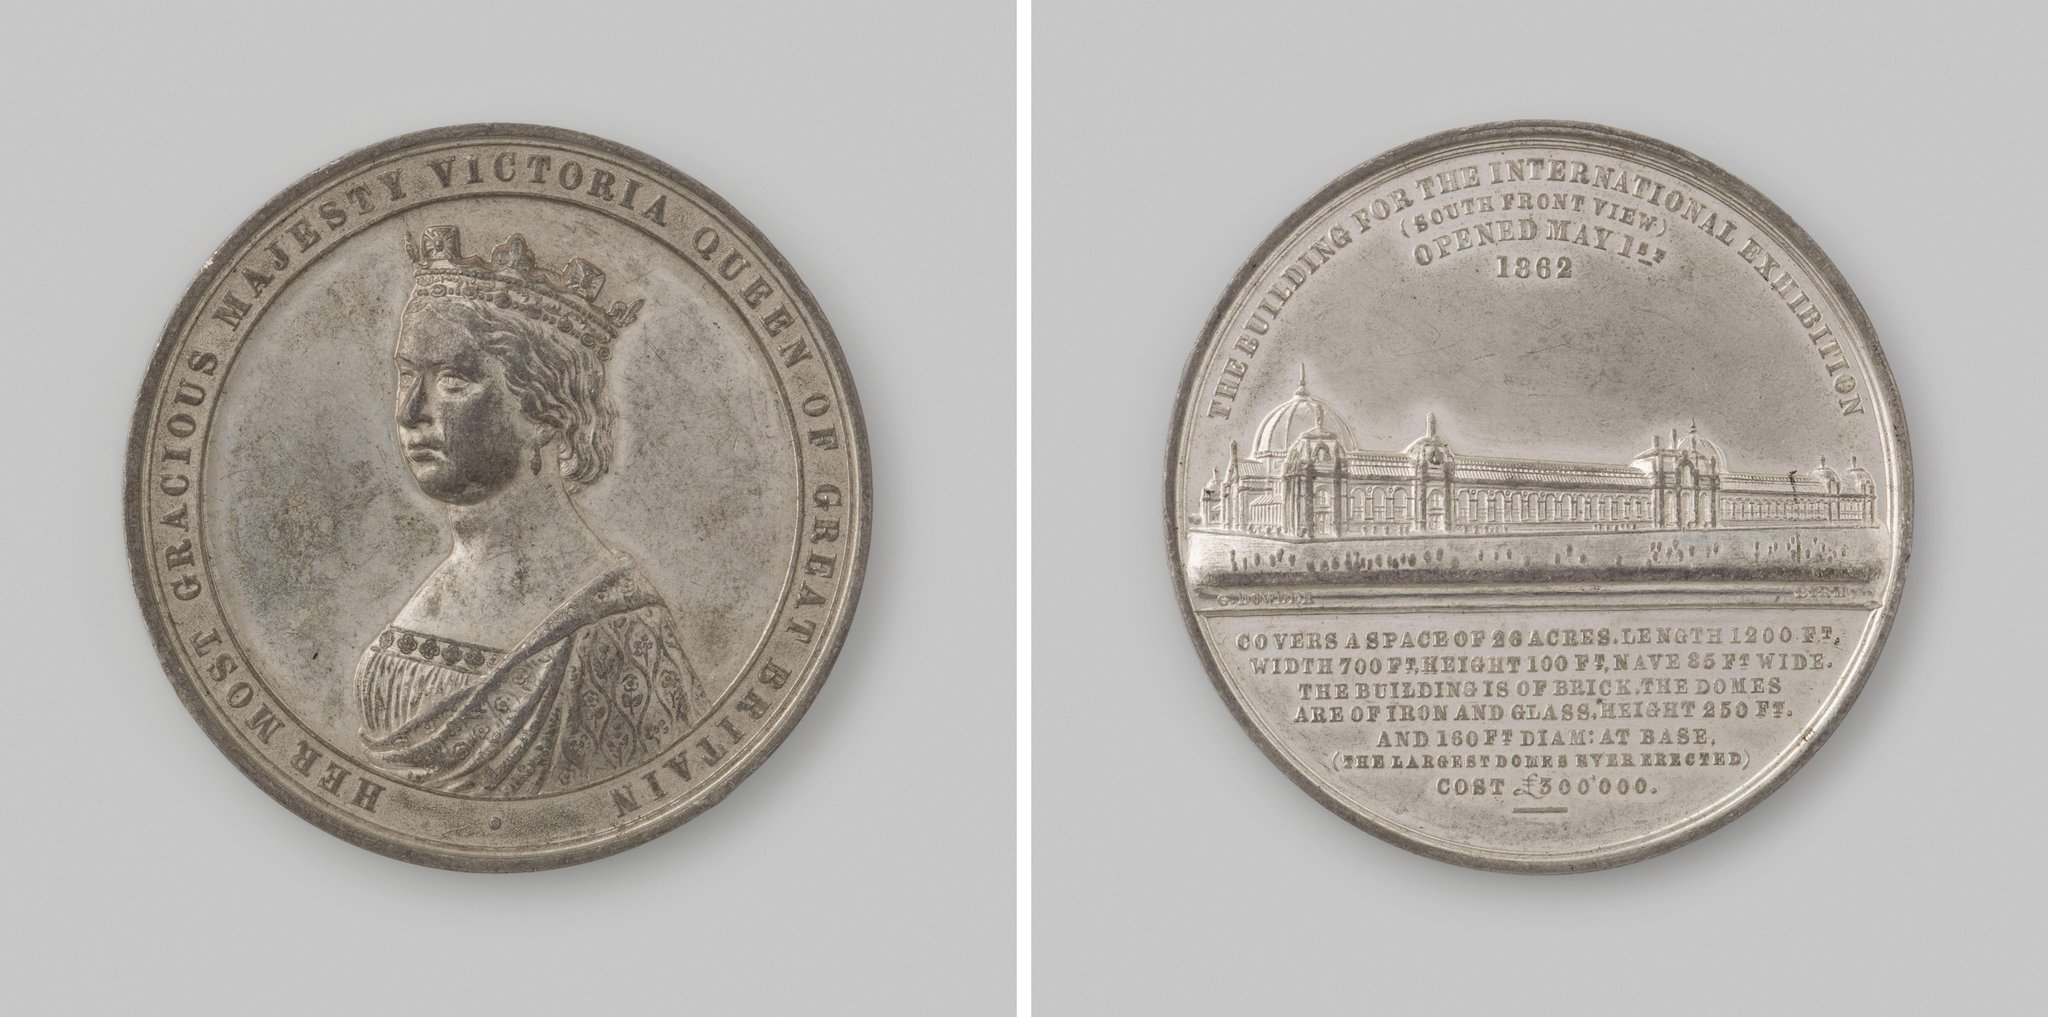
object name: history medal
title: Opening van het tentoonstellingsgebouw van Crystal Palace te Sydenham 1862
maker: george dowler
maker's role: modelleur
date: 1862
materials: tin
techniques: striking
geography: birmingham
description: Tinnen penning, op de voorzijde het borstbeeld van Koningin Victoria naar links met omschrift, op de keerzijde vier regels tekst, het tentoonstellingsgebouw en zeven regels afsnedetekst.